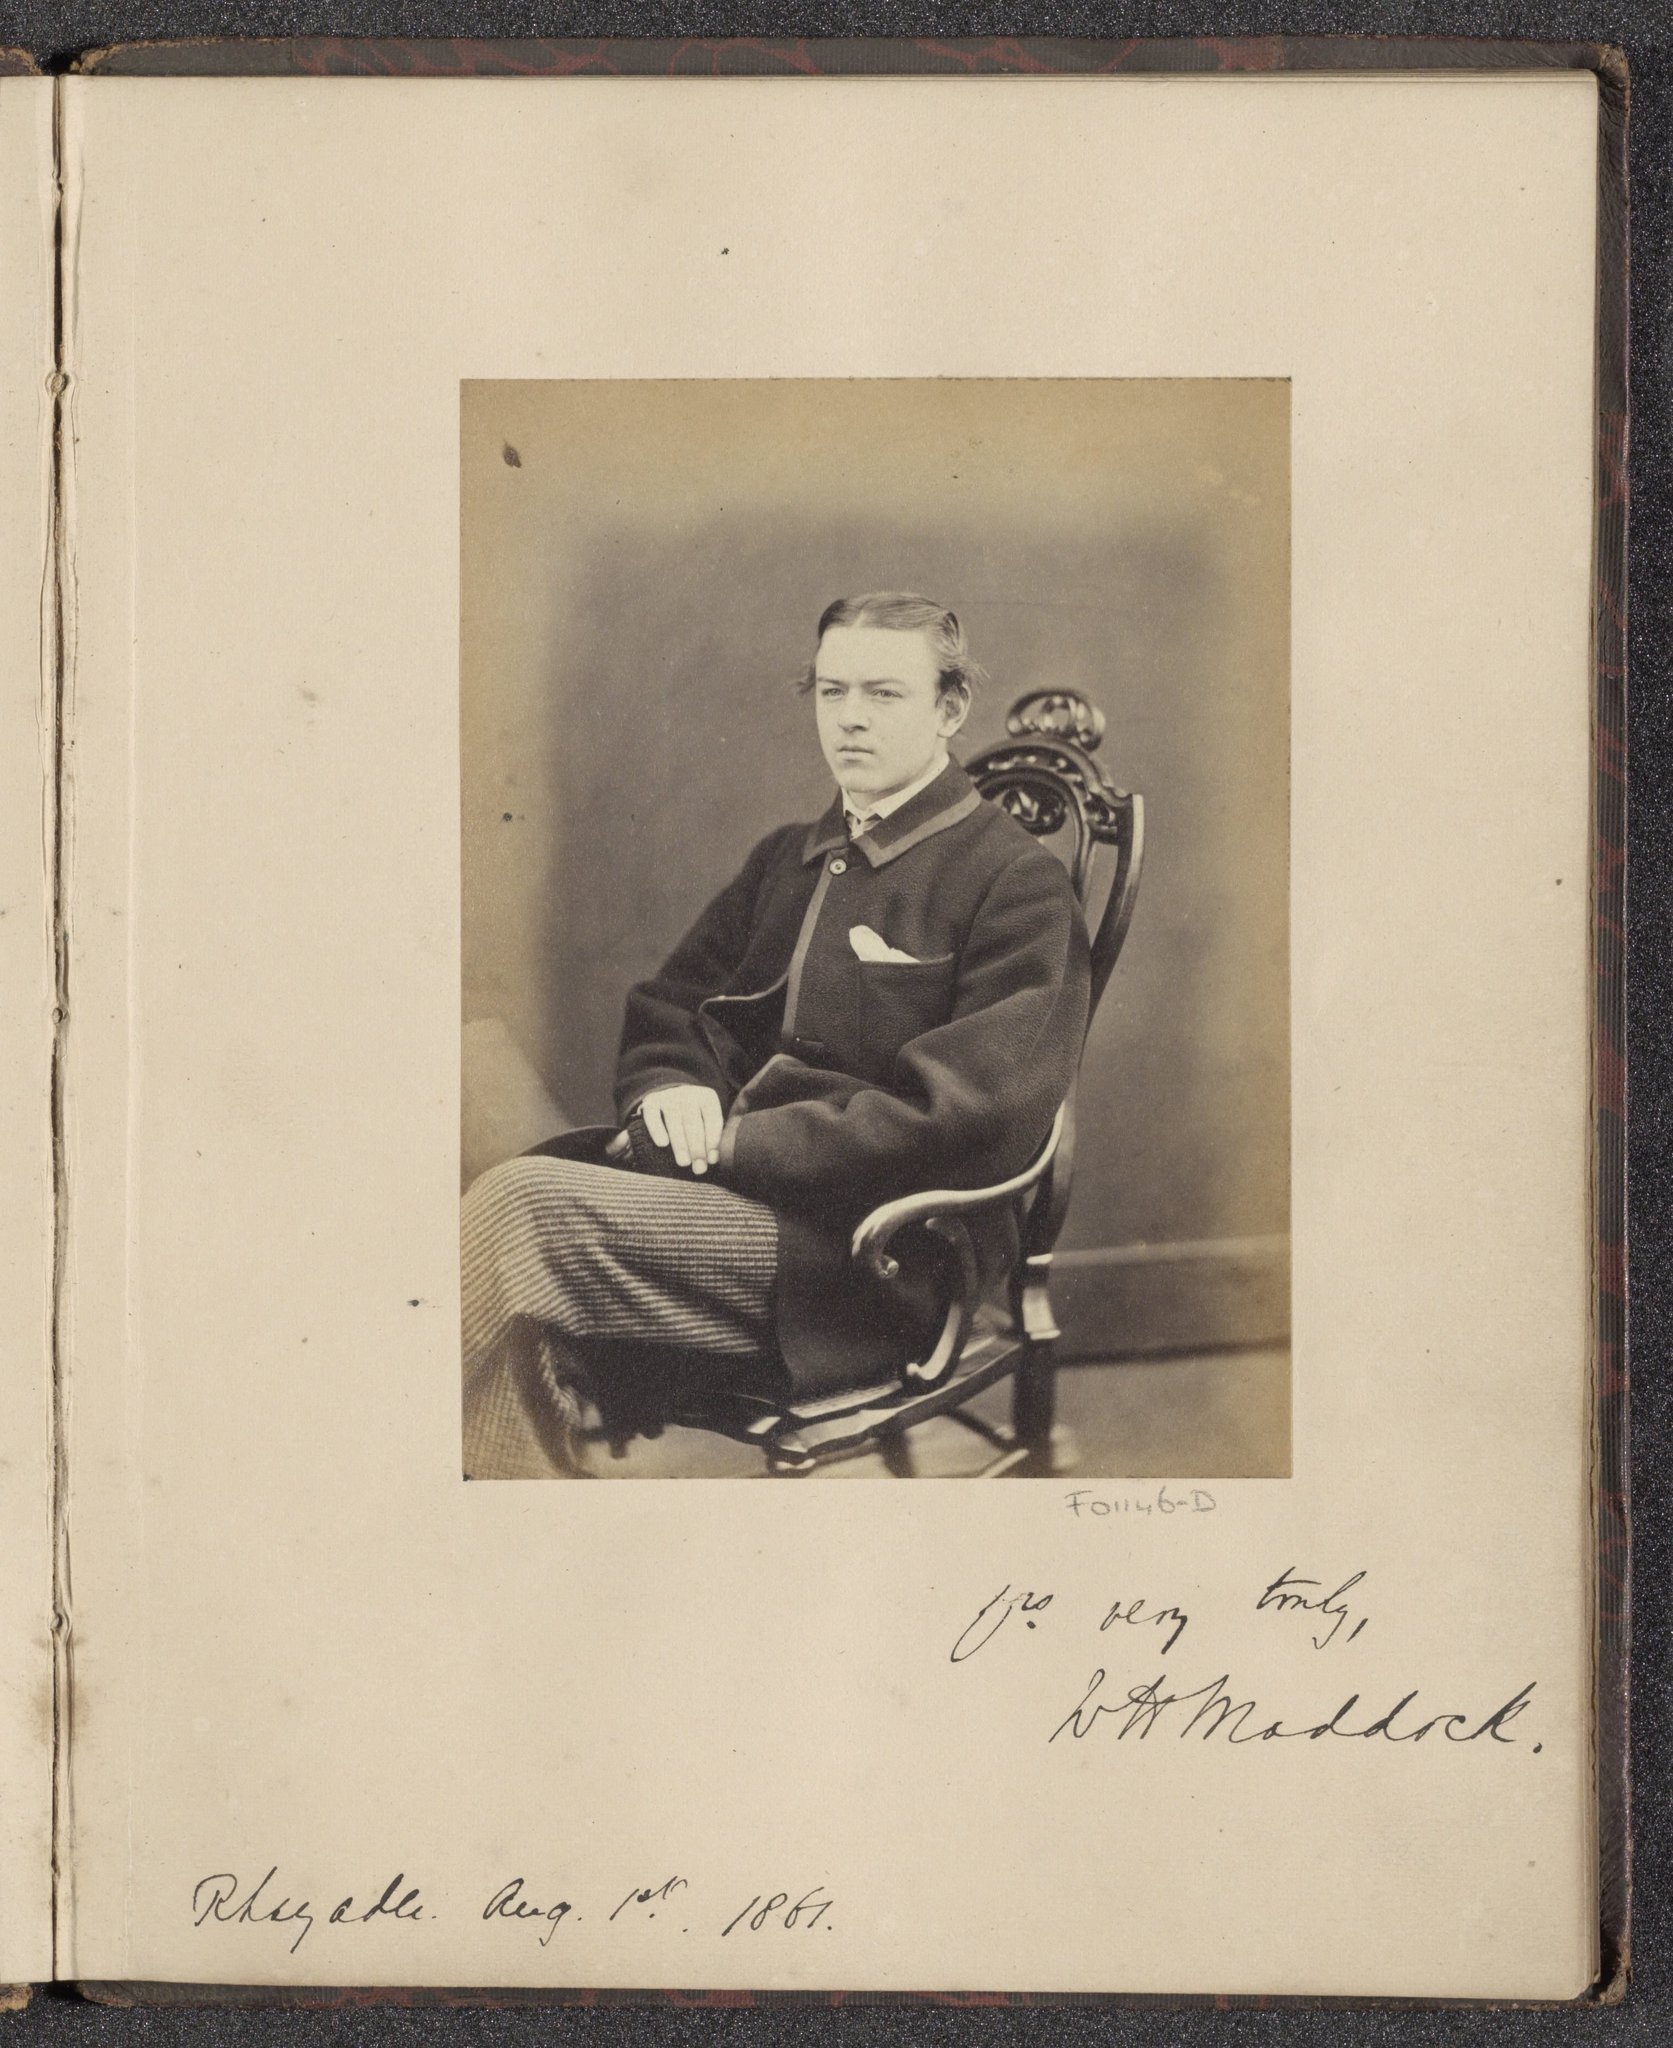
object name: photograph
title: W.H. Maddock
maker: j. bagnall evans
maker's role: fotograaf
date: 1860-1861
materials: paper, photographic support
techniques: albumen print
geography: oxford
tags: armchair, seat, trousers, breeches, higher education, e.g.: teacher's college (+ pupil), university education, youth, adolescent, hairdress, student, coat, cape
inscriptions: inscription: ‘Yrs. very truly, W.H. Maddock, Rhayadle Aug. 1st. 1861’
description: Onderdeel van Fotoalbum met 6 portretten van studenten van het Jesus College in Oxford.